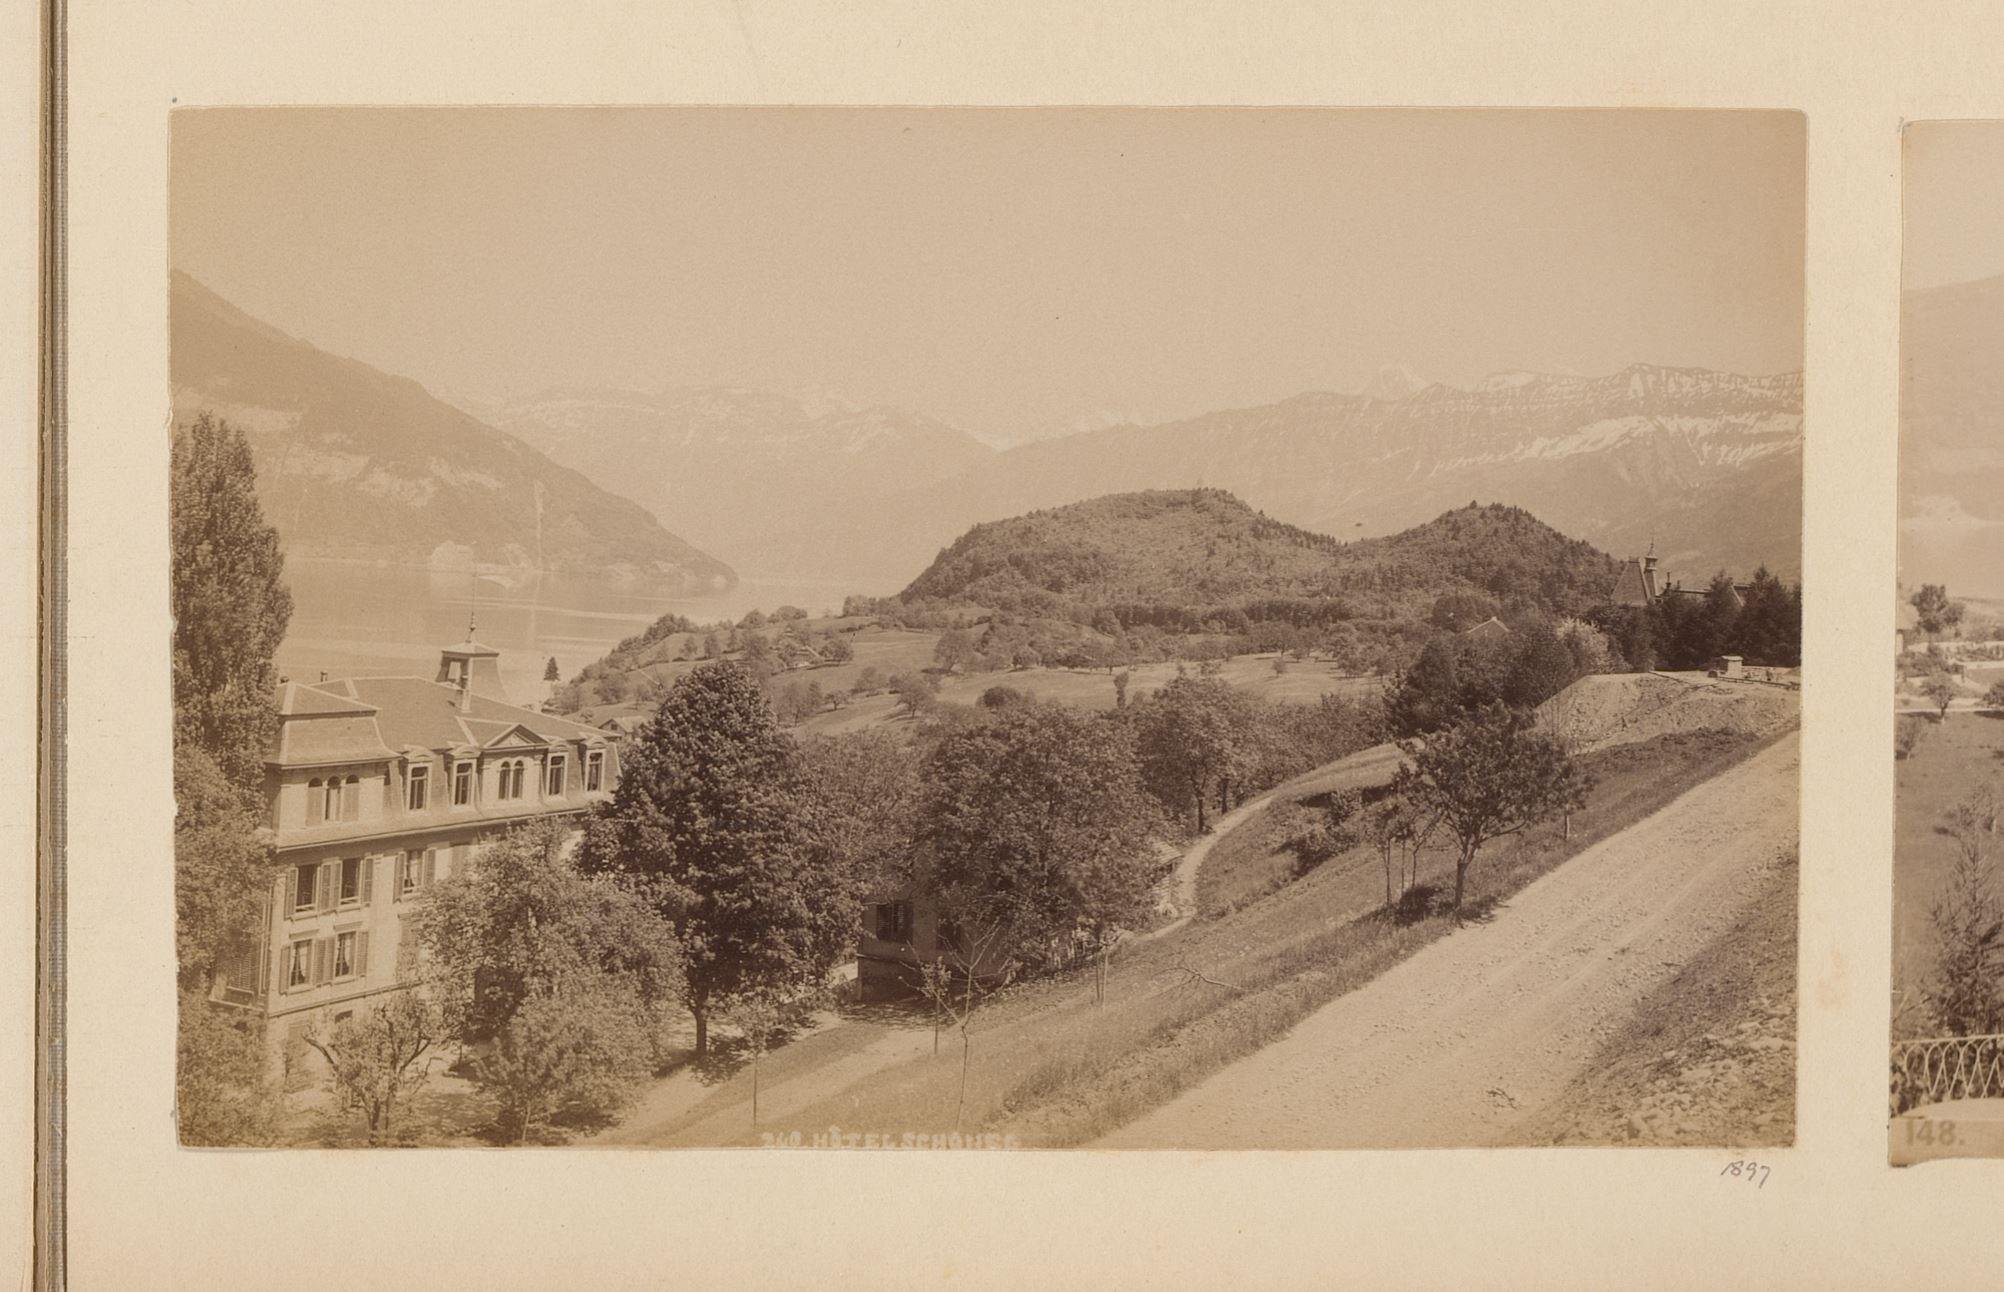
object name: photograph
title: Gezicht op bergen en een meer te Zwitserland, vermoedelijk de Thunersee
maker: Anonymous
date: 1897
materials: photographic support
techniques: albumen print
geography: bern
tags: lake, mountain-range, snow peaks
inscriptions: annotation: ‘1897’, inscription: ‘240. Hôtel Schoneg’